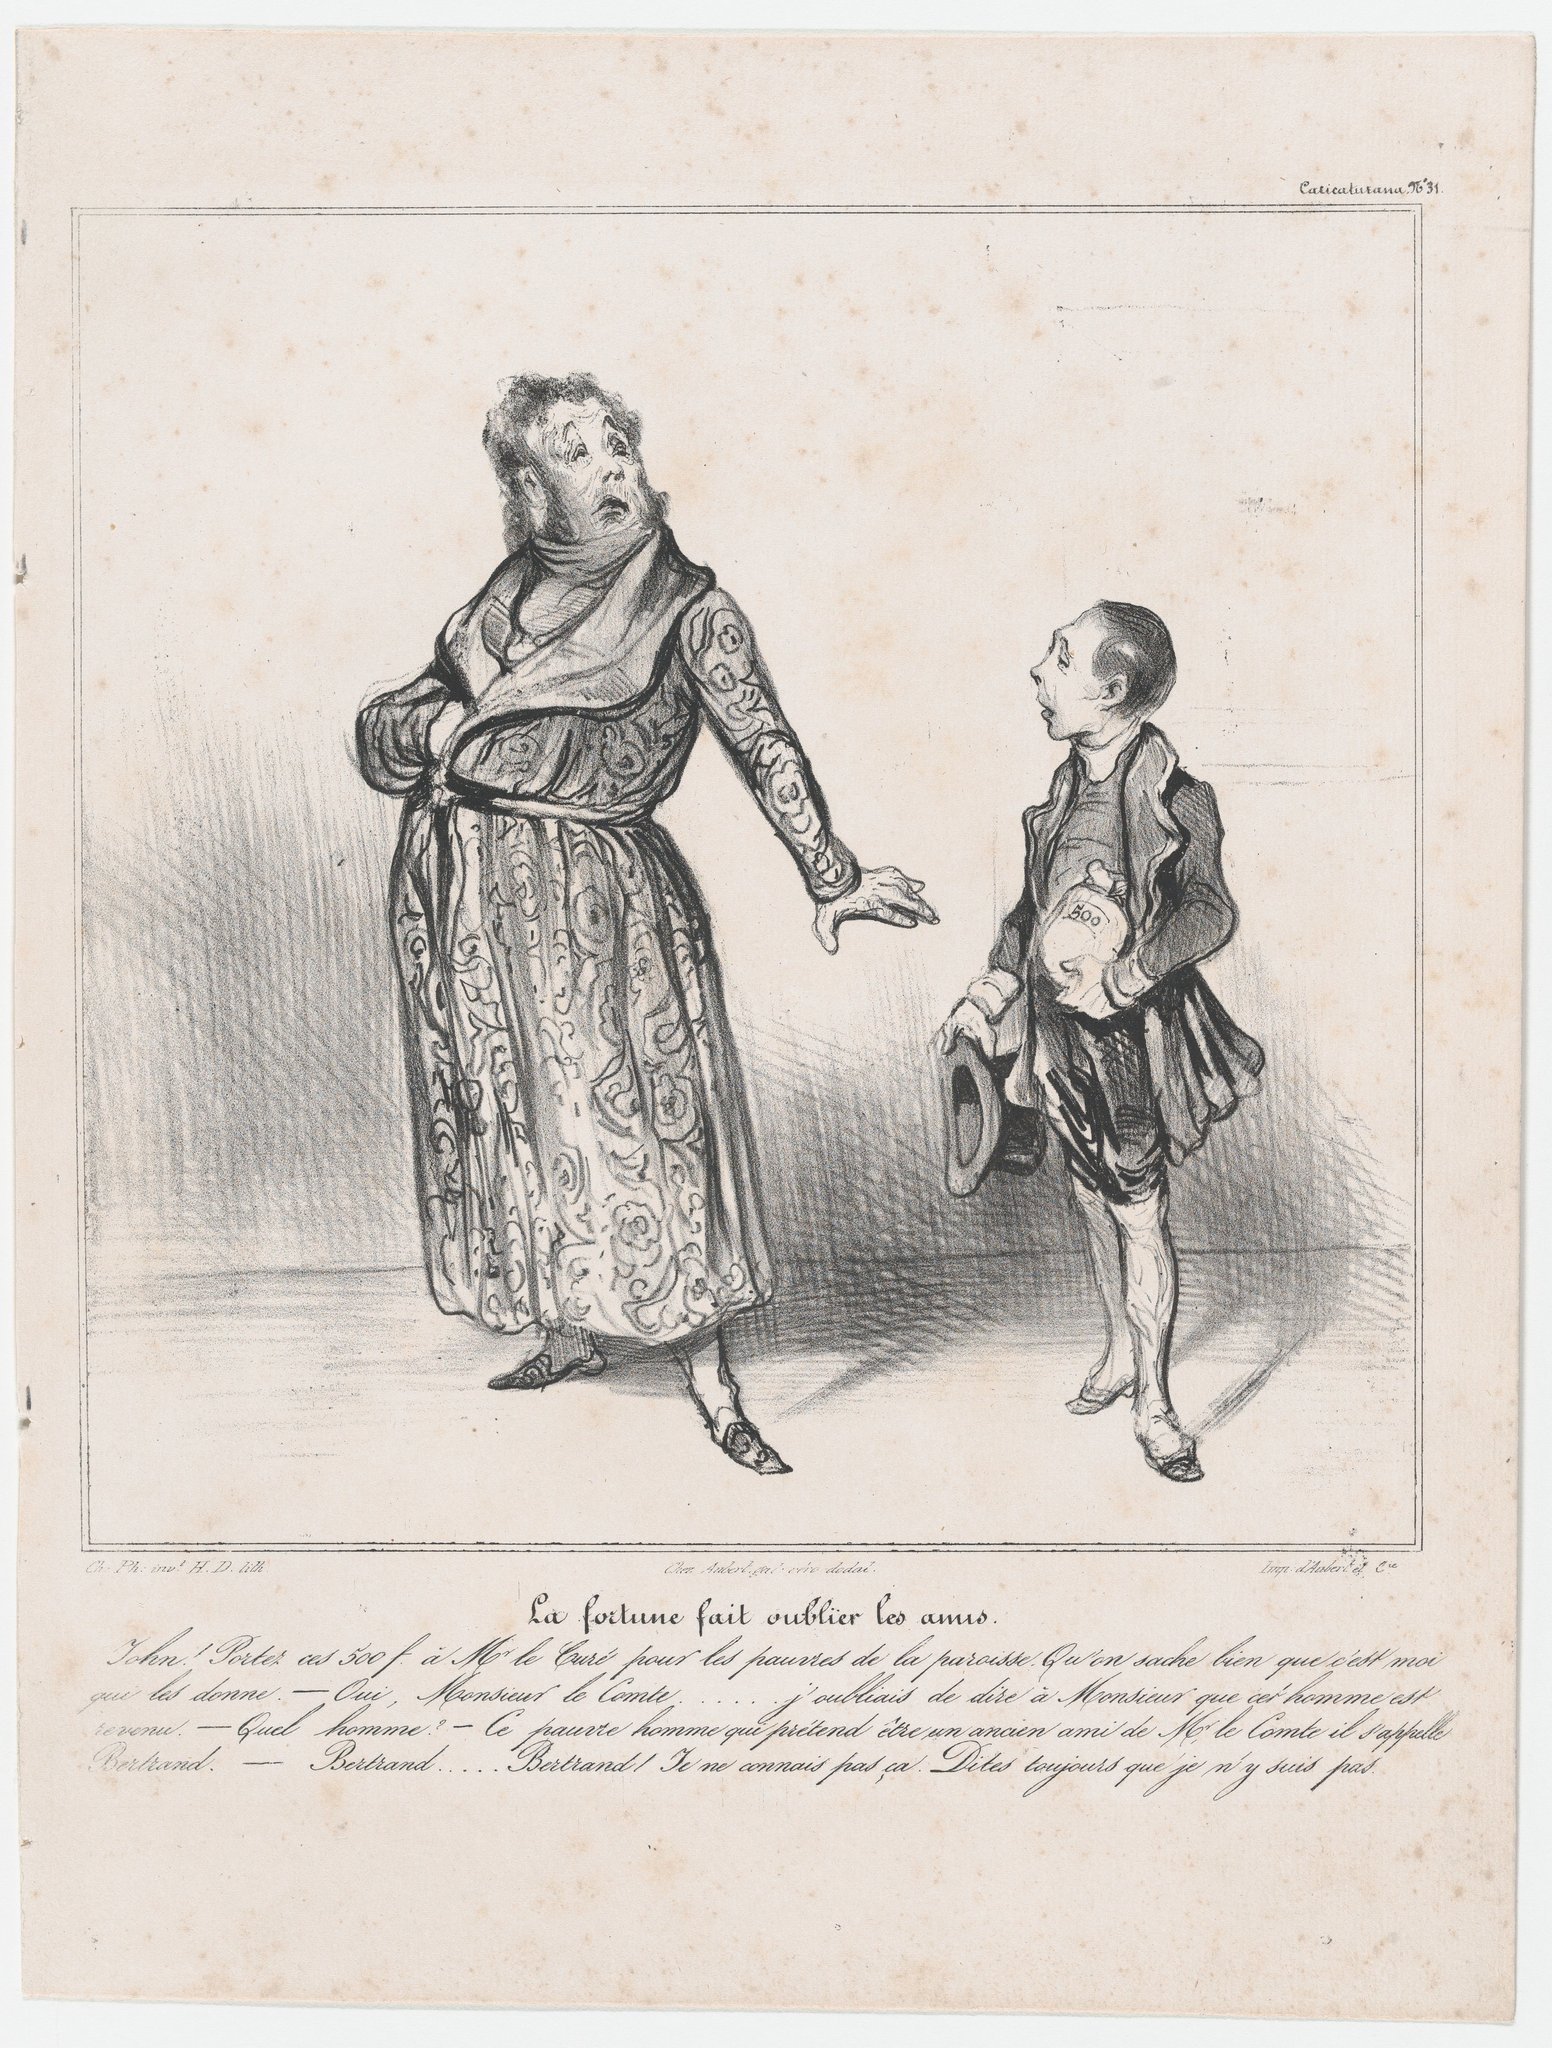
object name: print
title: Plate 31: Fortune makes one forget one's friends, from 'Caricaturana,' published in Les Robert Macaires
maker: honoré daumier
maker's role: artist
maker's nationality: french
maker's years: 1808-1879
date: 1838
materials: paper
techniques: lithograph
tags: men